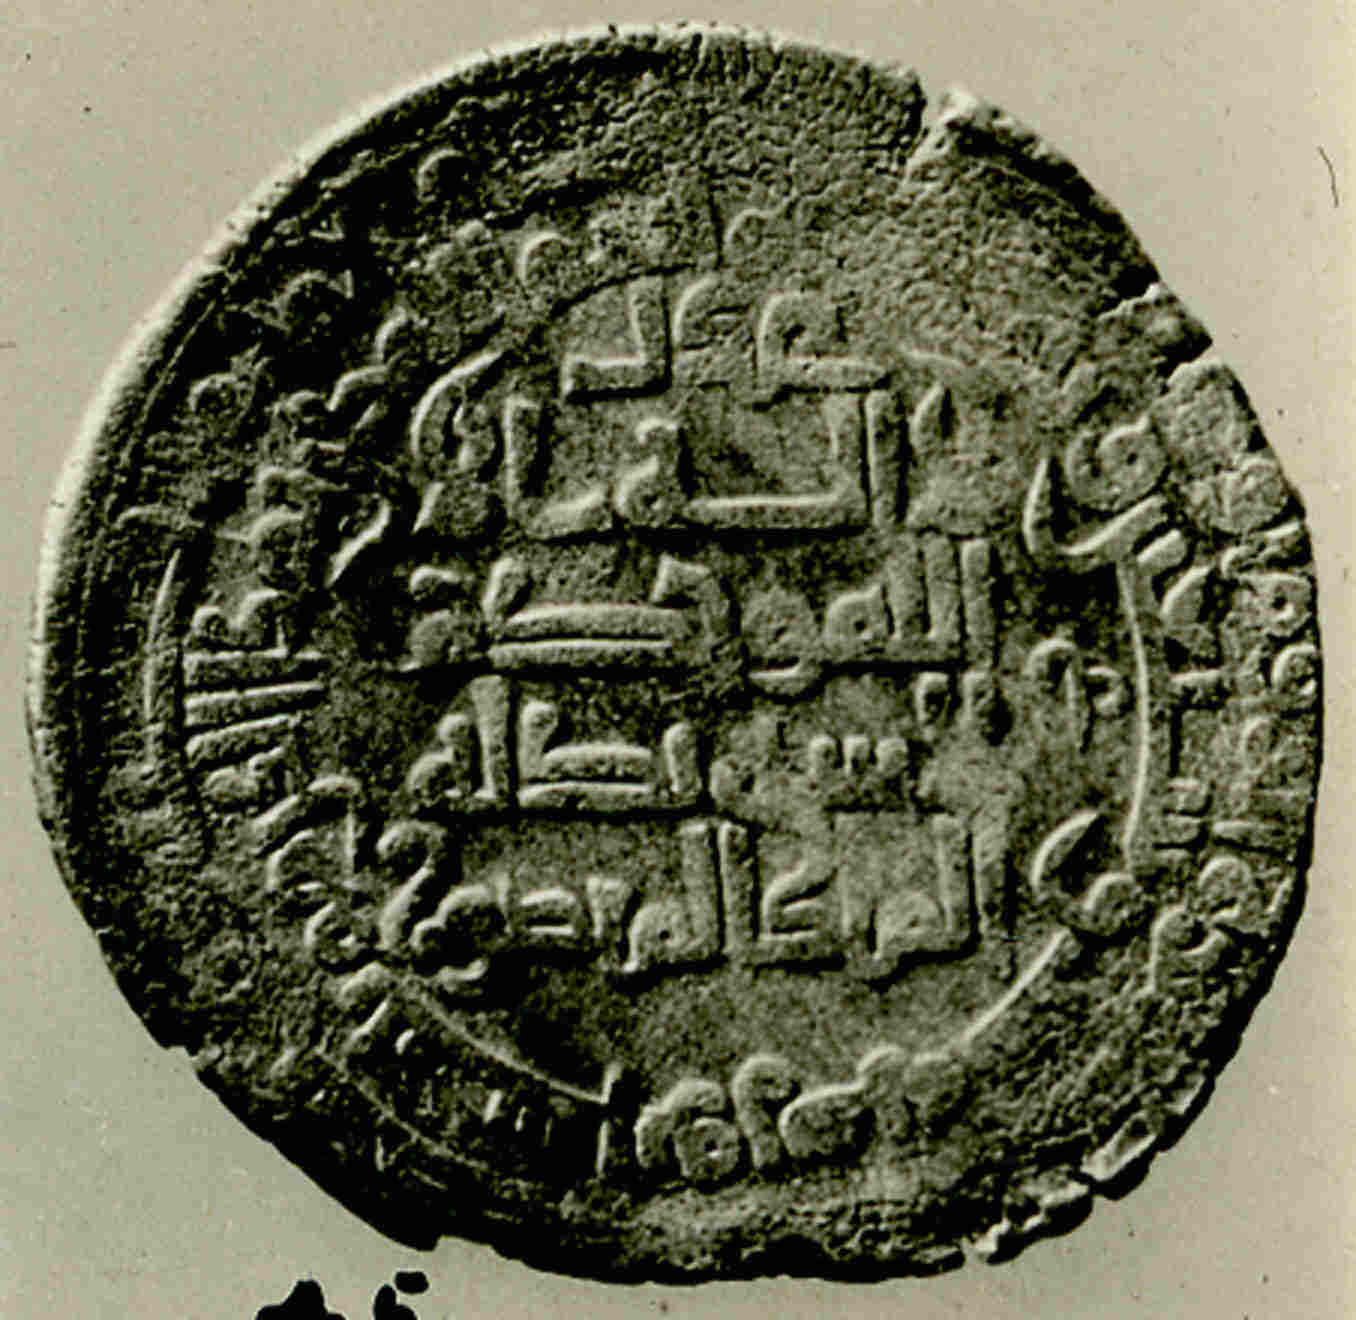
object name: coin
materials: silver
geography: iran